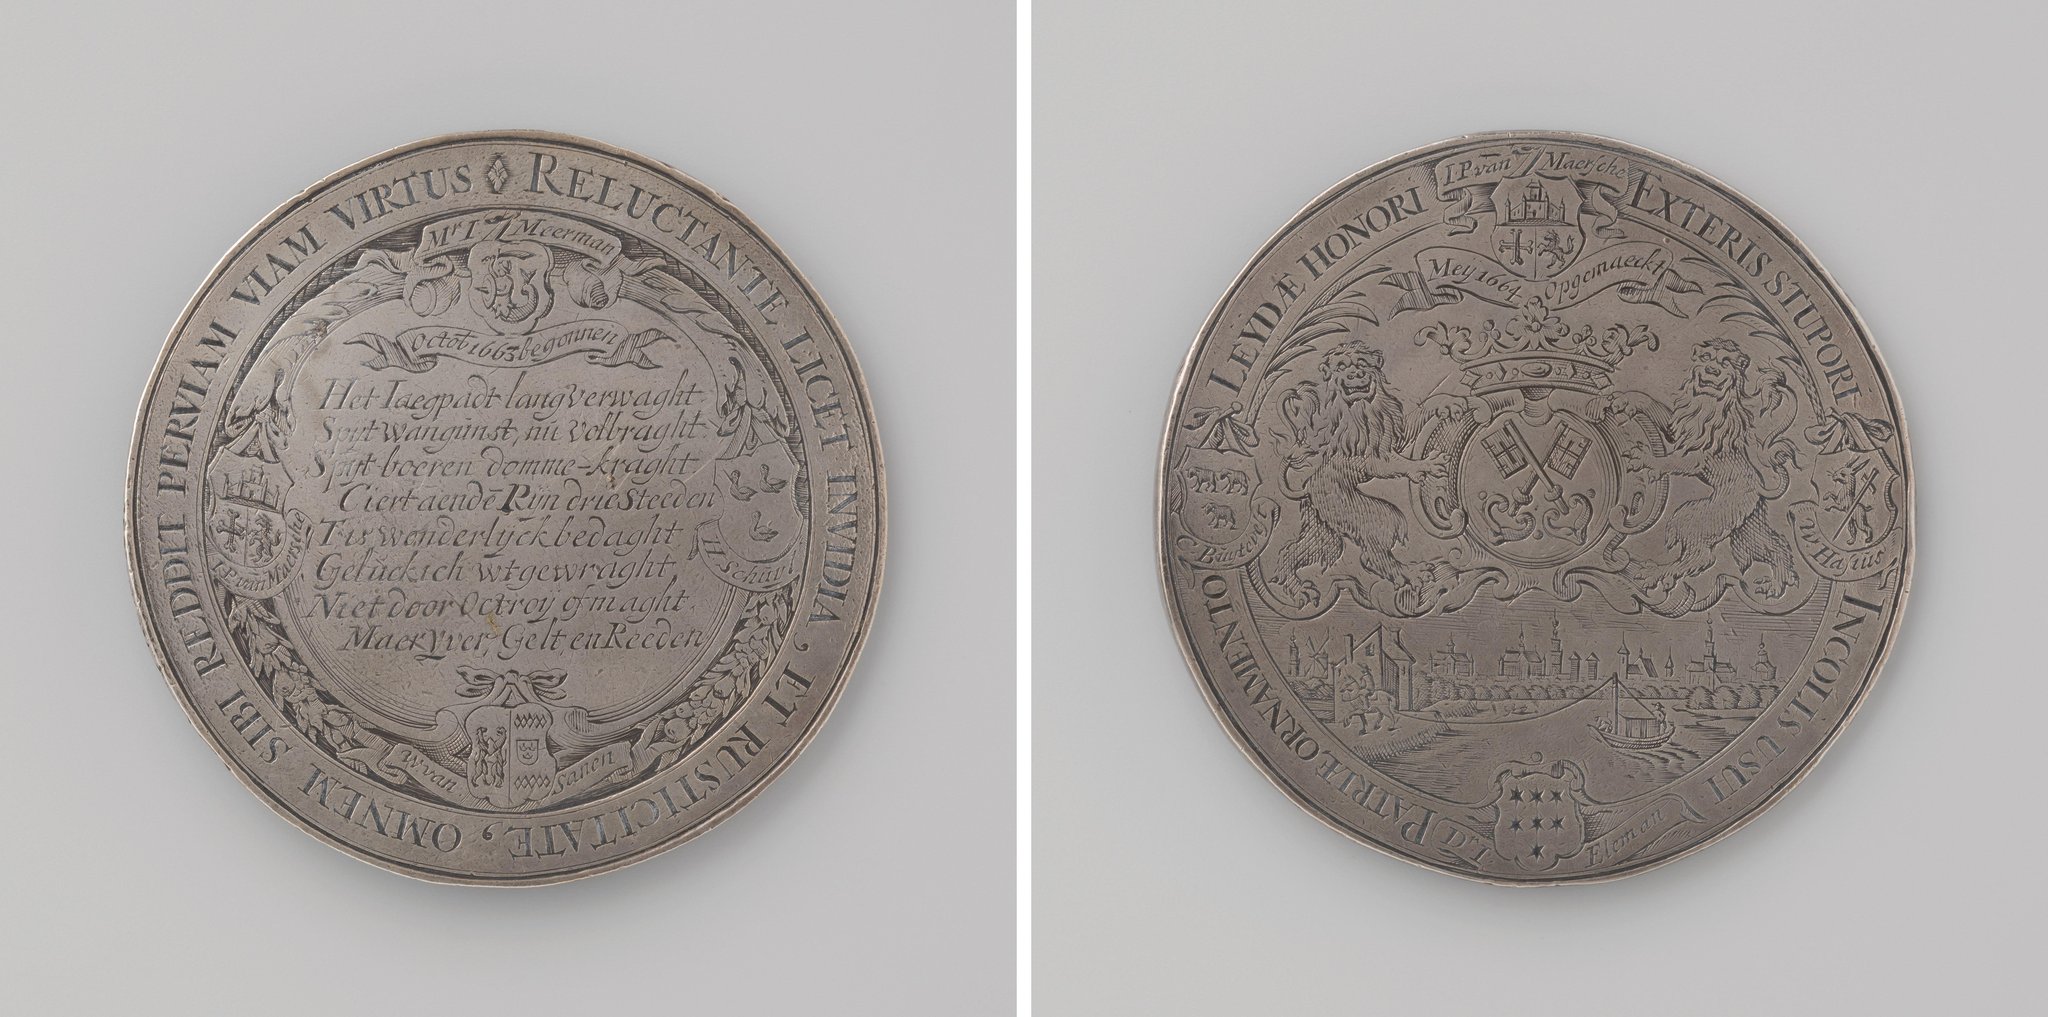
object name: history medal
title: Jaagpad van Leiden naar Utrecht voltooid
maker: arent schmeltzing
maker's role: medailleur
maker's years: -1710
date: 1664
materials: silver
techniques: engraving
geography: leiden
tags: leiden, utrecht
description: Zilveren penning. Voorzijde: opschrift binnen krans met vier wapenschilden boven wimpel met opschrift, binnen omschrift. Keerzijde: gekroond wapenschild van Leiden geflankeerd door twee leeuwen boven afbeelding van trekschuit voor stad, binnen rand met omschrift en vier wapenschilden.